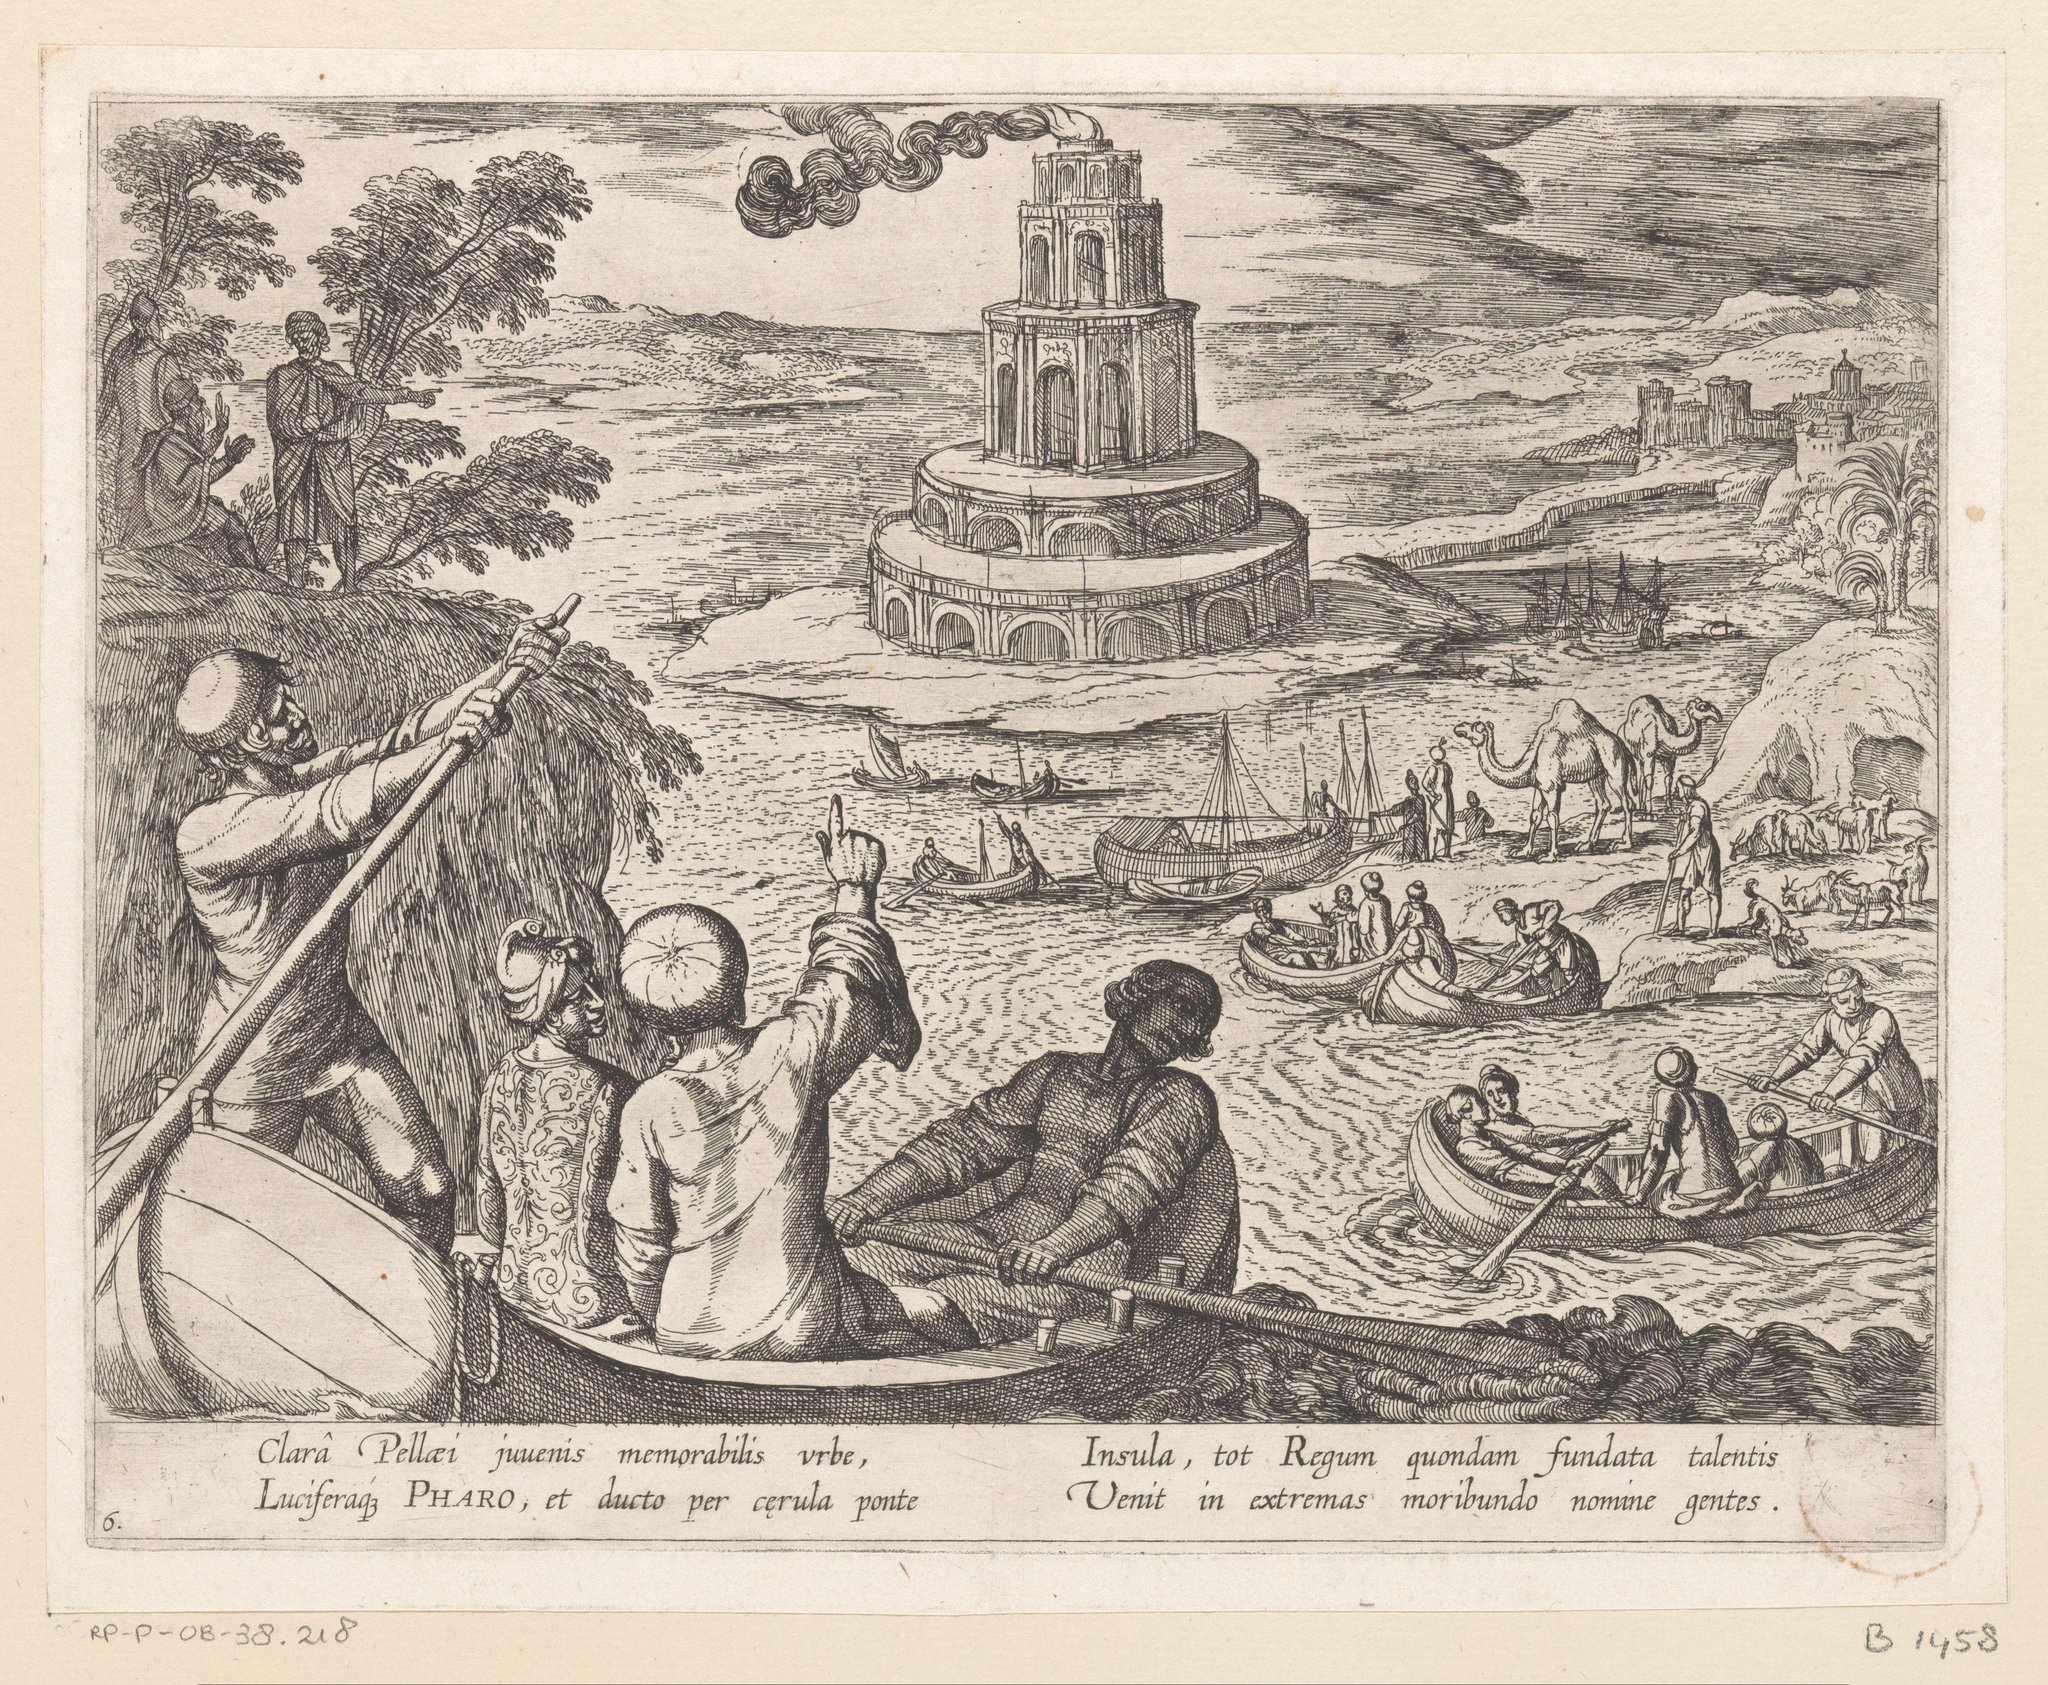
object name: print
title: De zeven wereldwonderen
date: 1608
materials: paper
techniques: etching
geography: antwerp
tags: lighthouse, lightship, the seven wonders of the world, pharos of alexandria (wonder of the world)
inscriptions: collector's mark: Lugt 240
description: Kustlandschap met de Vuurtoren van Alexandrië. Op de voorgrond mannen in roeibootjes. Tekst in het Latijn in ondermarge.